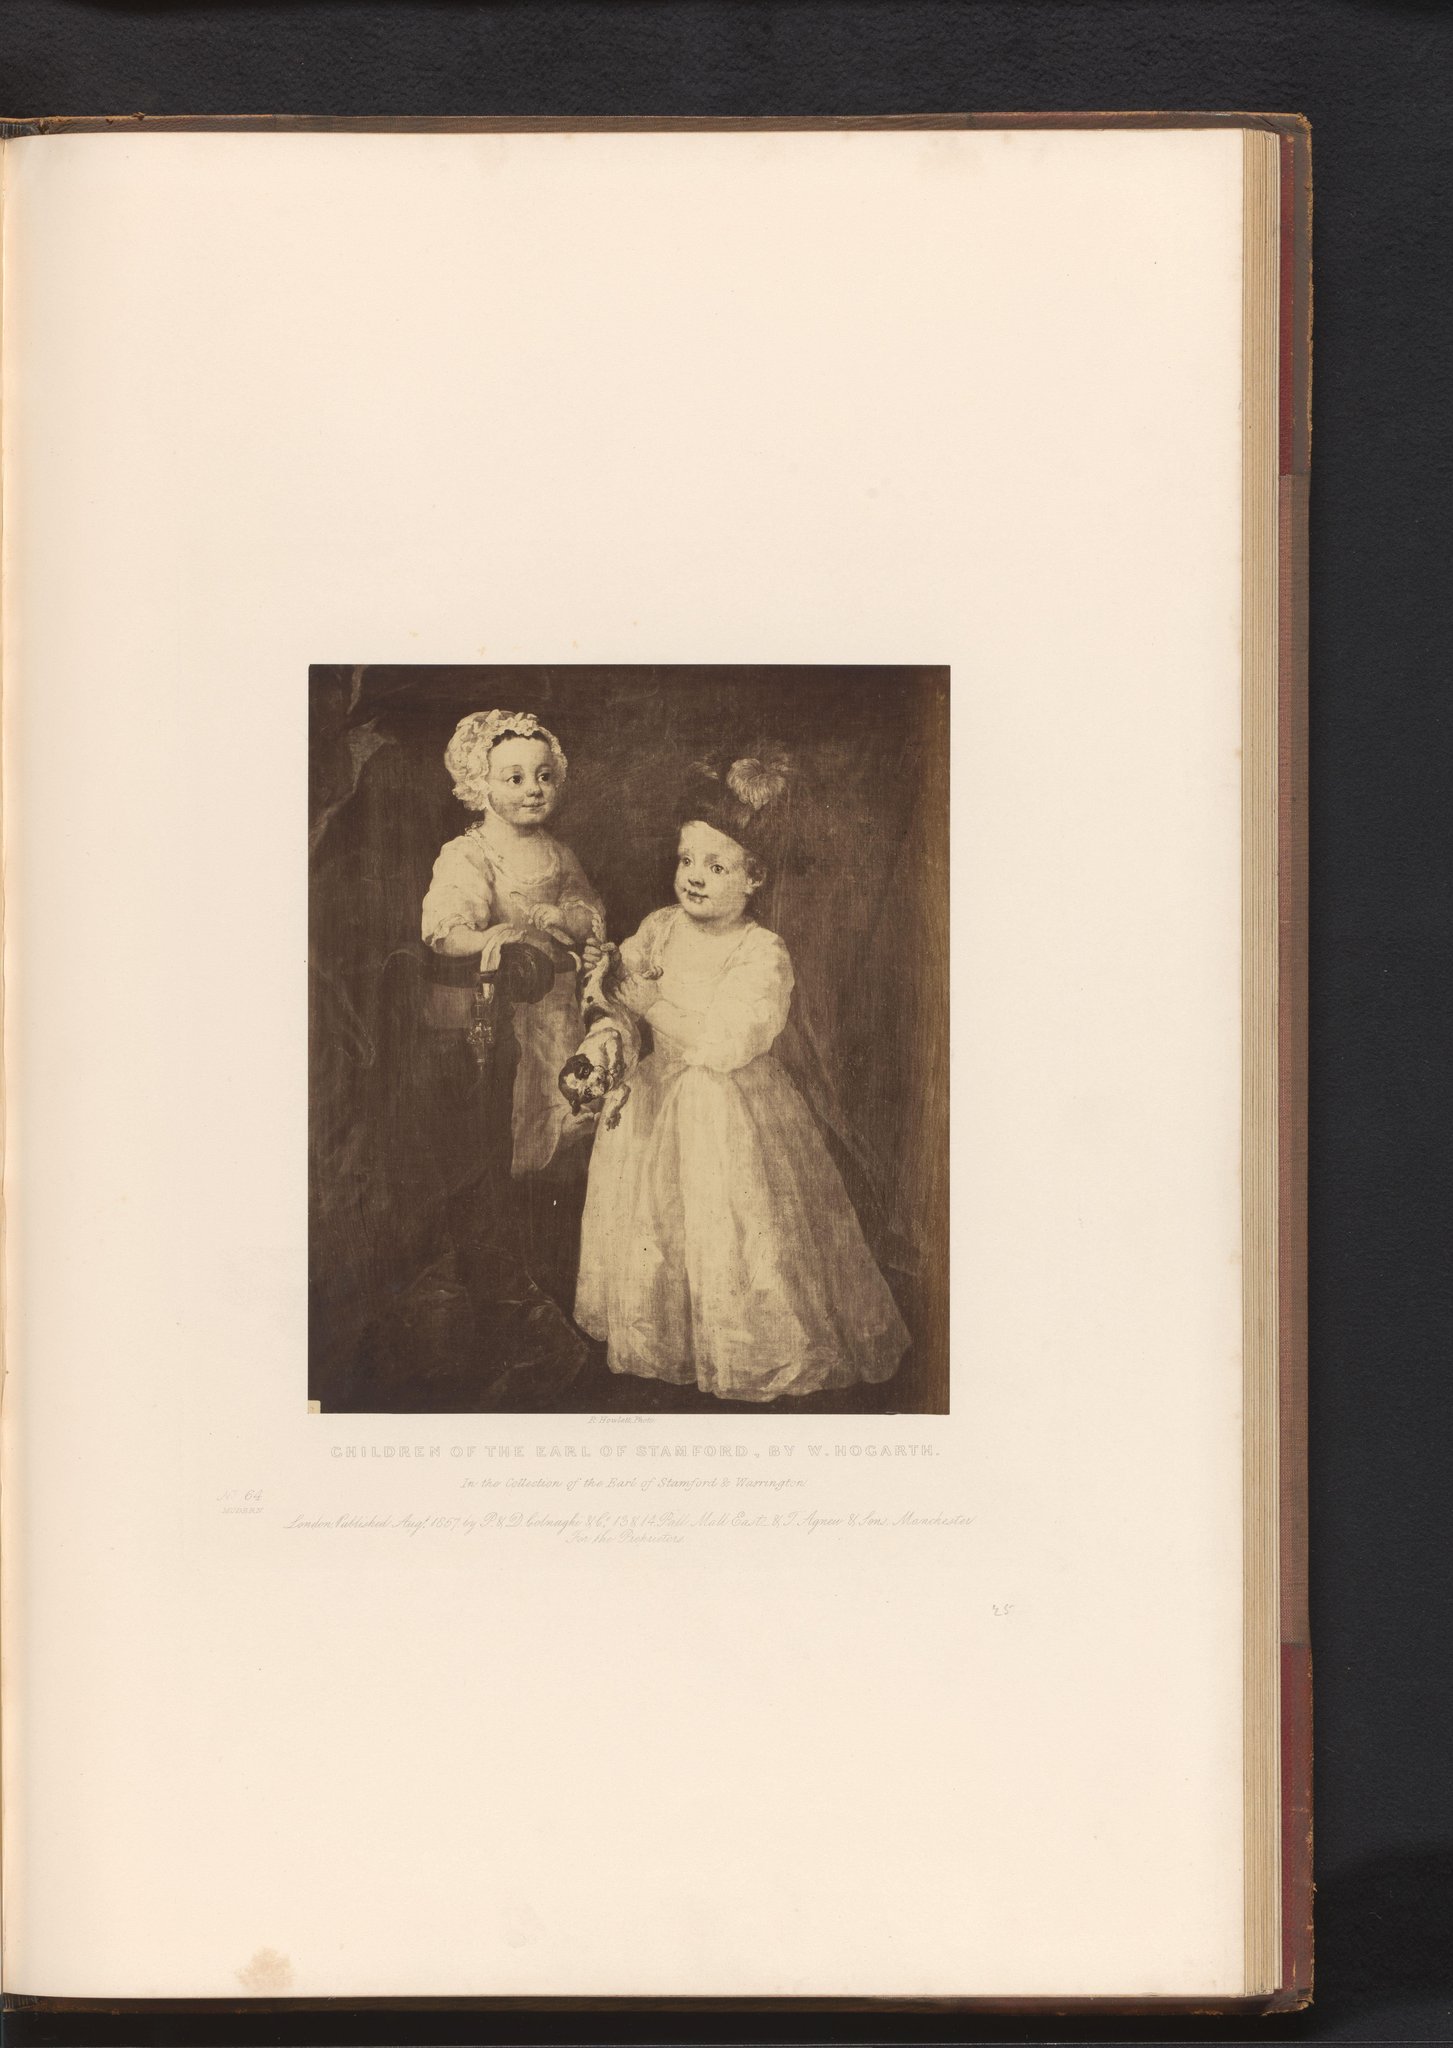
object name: reproduction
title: Fotoreproductie van een schilderij van een portret van de kinderen van de graaf van Stamford, door William Hogarth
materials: photographic support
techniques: albumen print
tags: historical persons not known by name - bb - woman, girl (child between toddler and youth)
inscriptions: inscription: ‘In the Collection of The Earl of Stamford & Warrington./ London, Published Augt, 1857, by P. & D. Colnaghi & Co, 13 & 14, Pall Mall East & T. Agneur & Sons, Manchester./ For the Proprietors.’, number: ‘25’, number: ‘No. 64./ MODERN.’